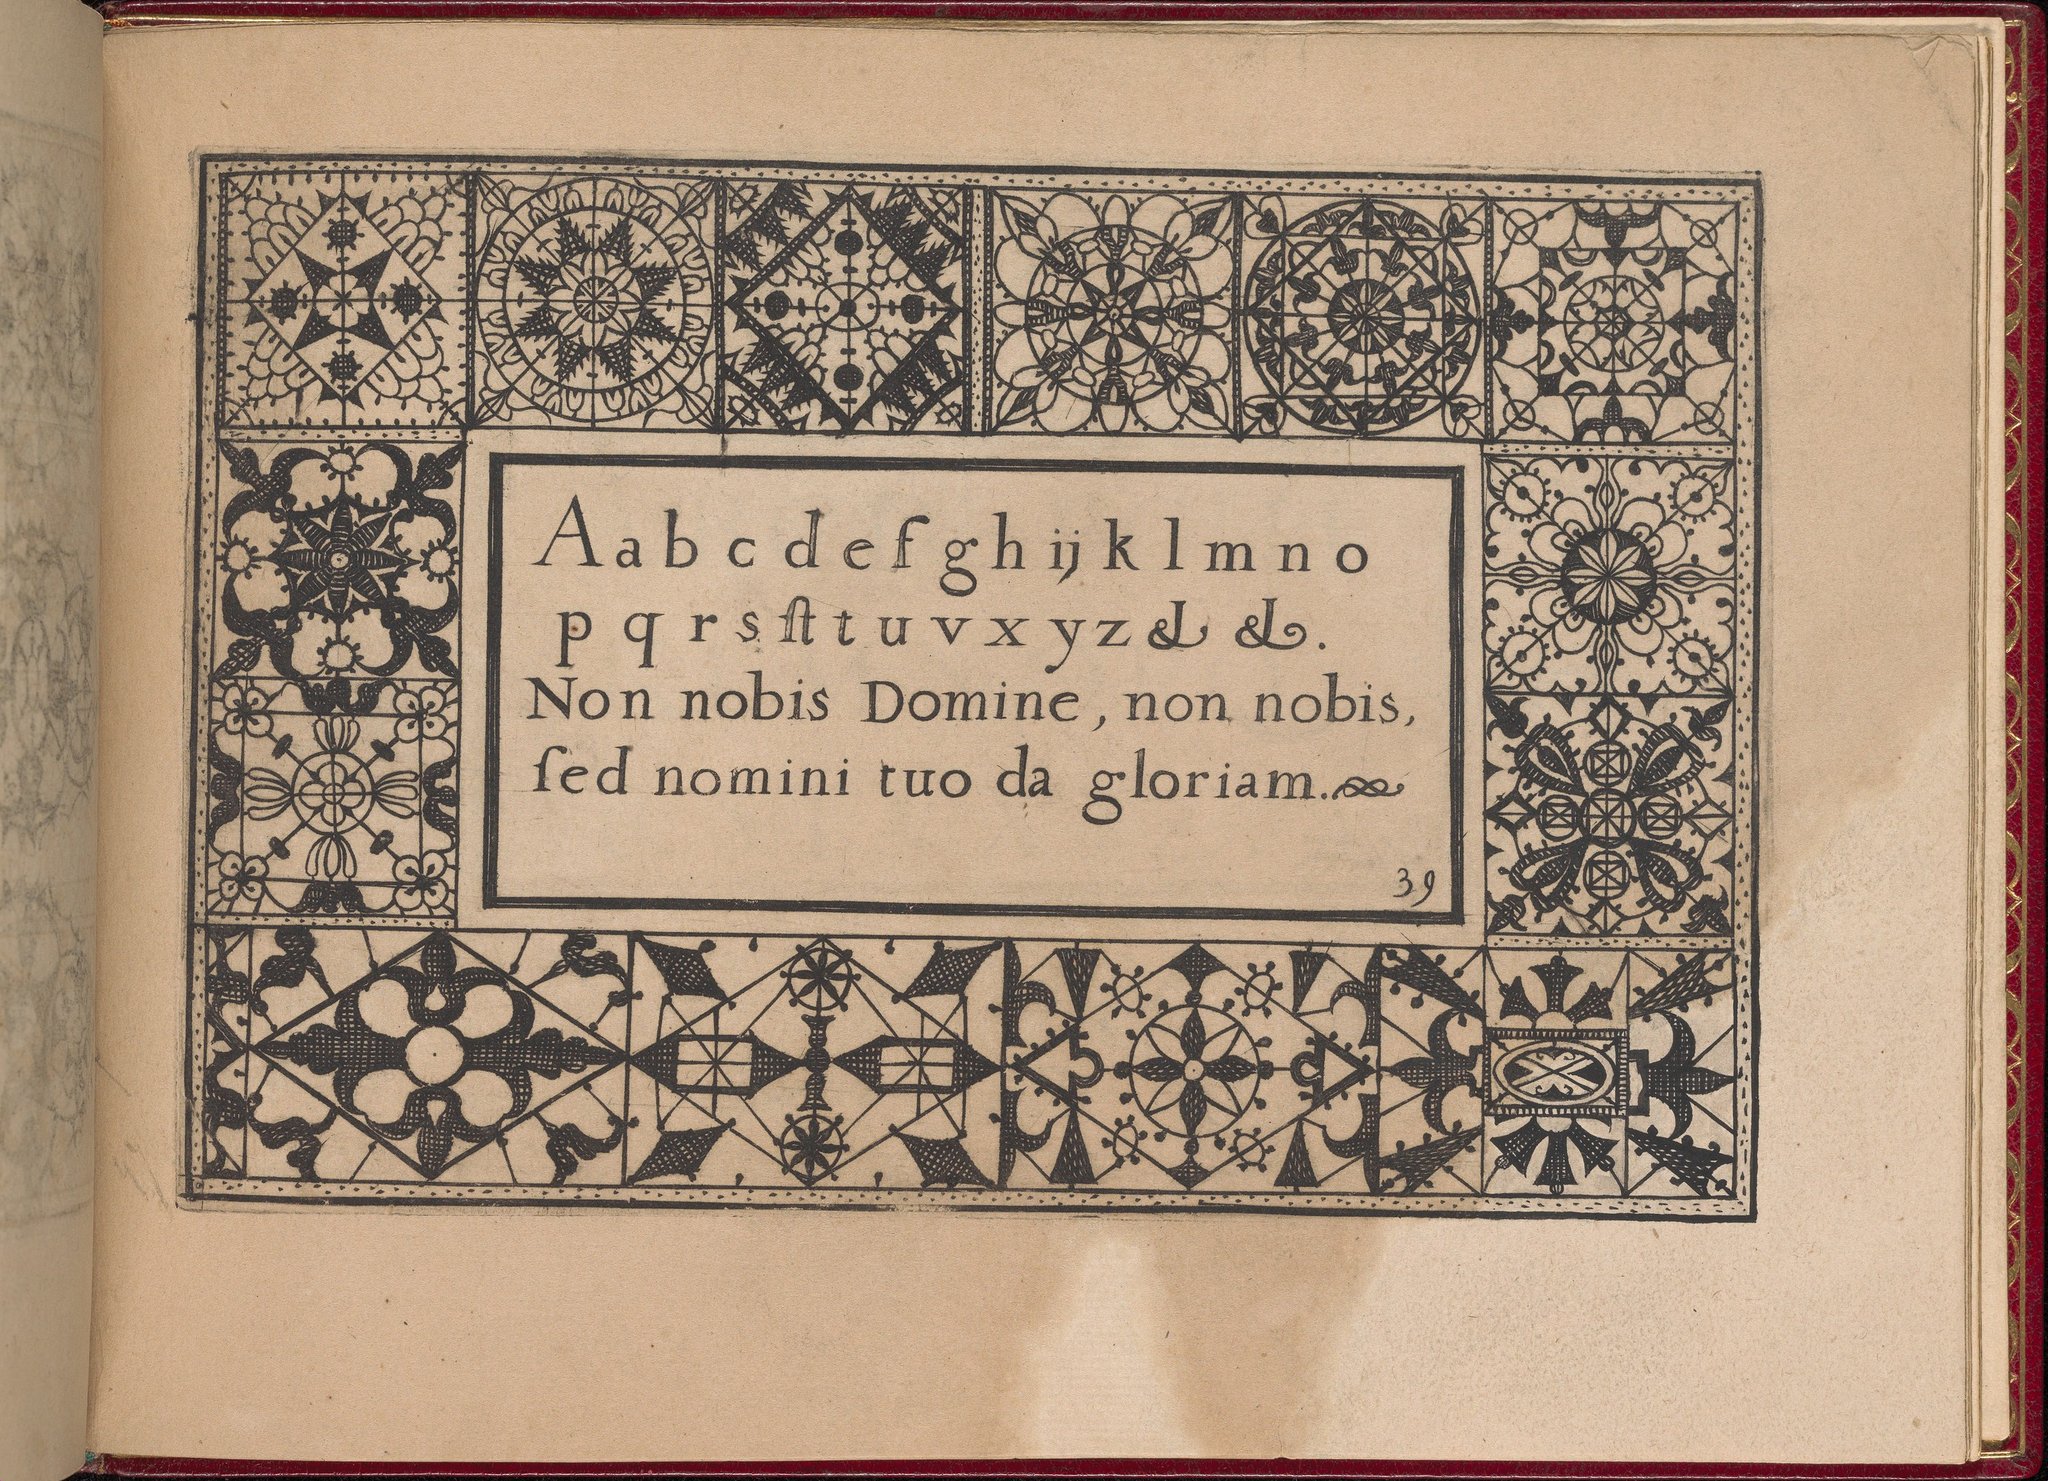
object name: book print ornament architecture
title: Ghirlanda: Di sei vaghi fiori scielti da piu famosi Giardini d'Italia, page 47 (recto)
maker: pietro paulo tozzi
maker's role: designer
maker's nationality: italian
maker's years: 1593-1628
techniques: drawing, etching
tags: ornament